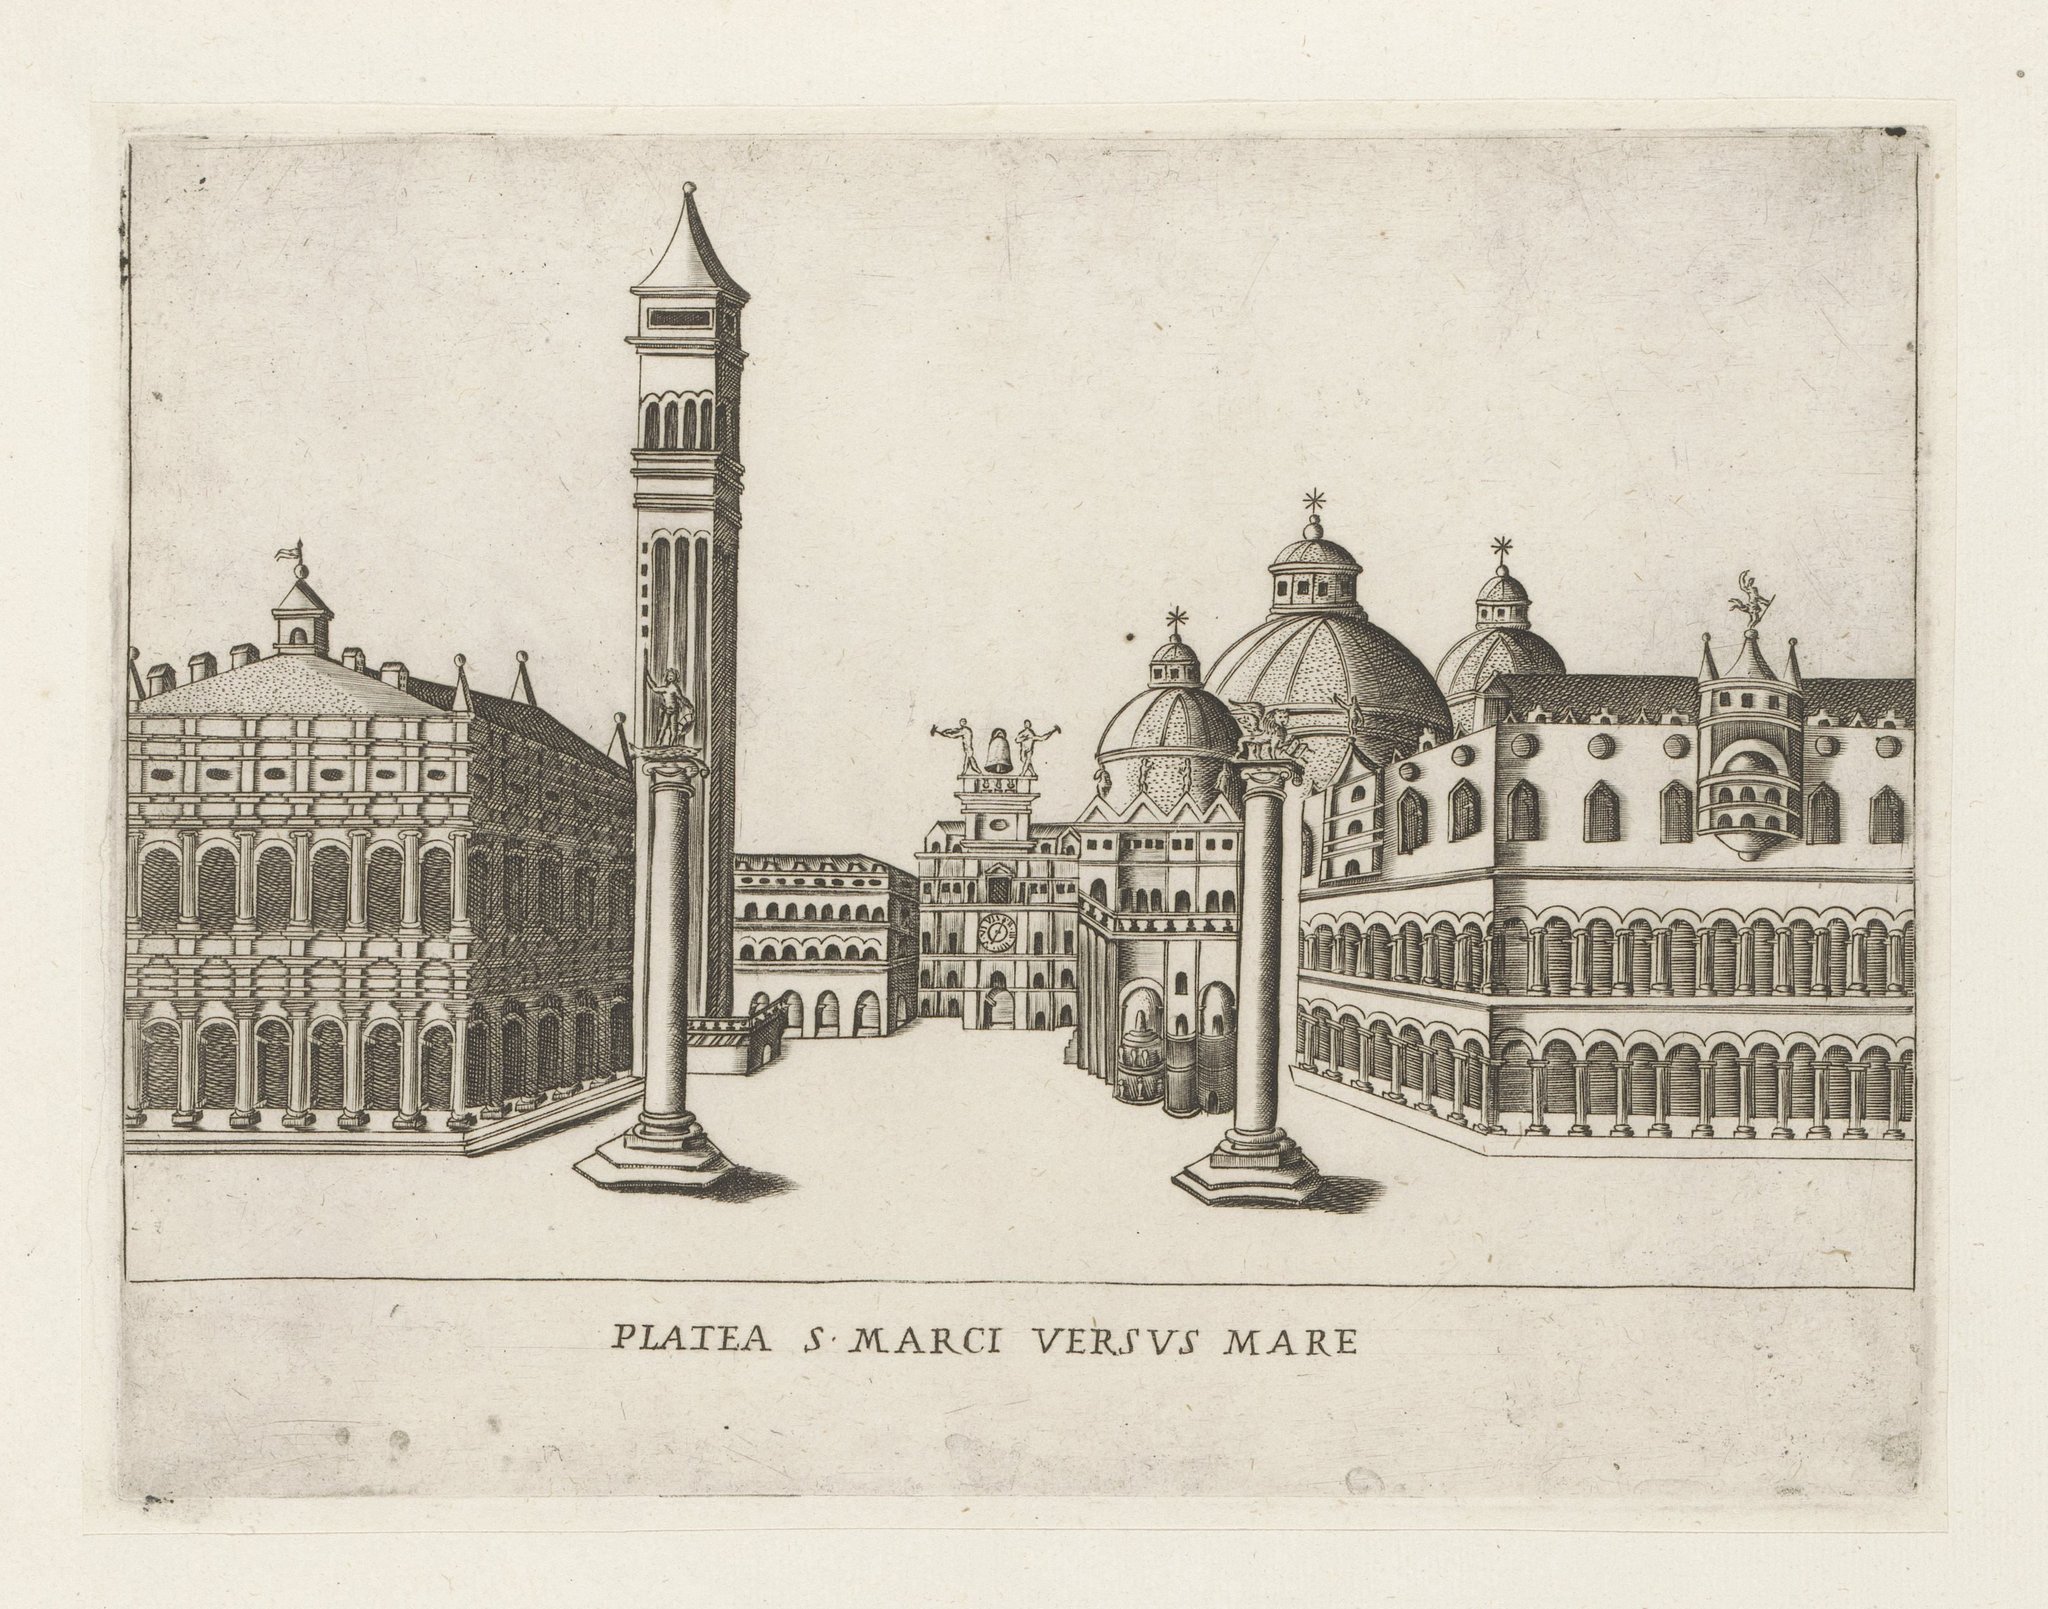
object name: album leaf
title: Beroemde gebouwen in Rome en daarbuiten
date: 1638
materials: paper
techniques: etching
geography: rome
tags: square, place, circus, etc., column, pillar ~ architecture, church (exterior)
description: Gezicht op het San Marcoplein te Venetië, met de zuil met de gevleugende leeuw, het Dogepaleis en de San Marco. De prent maakt deel uit van een album.